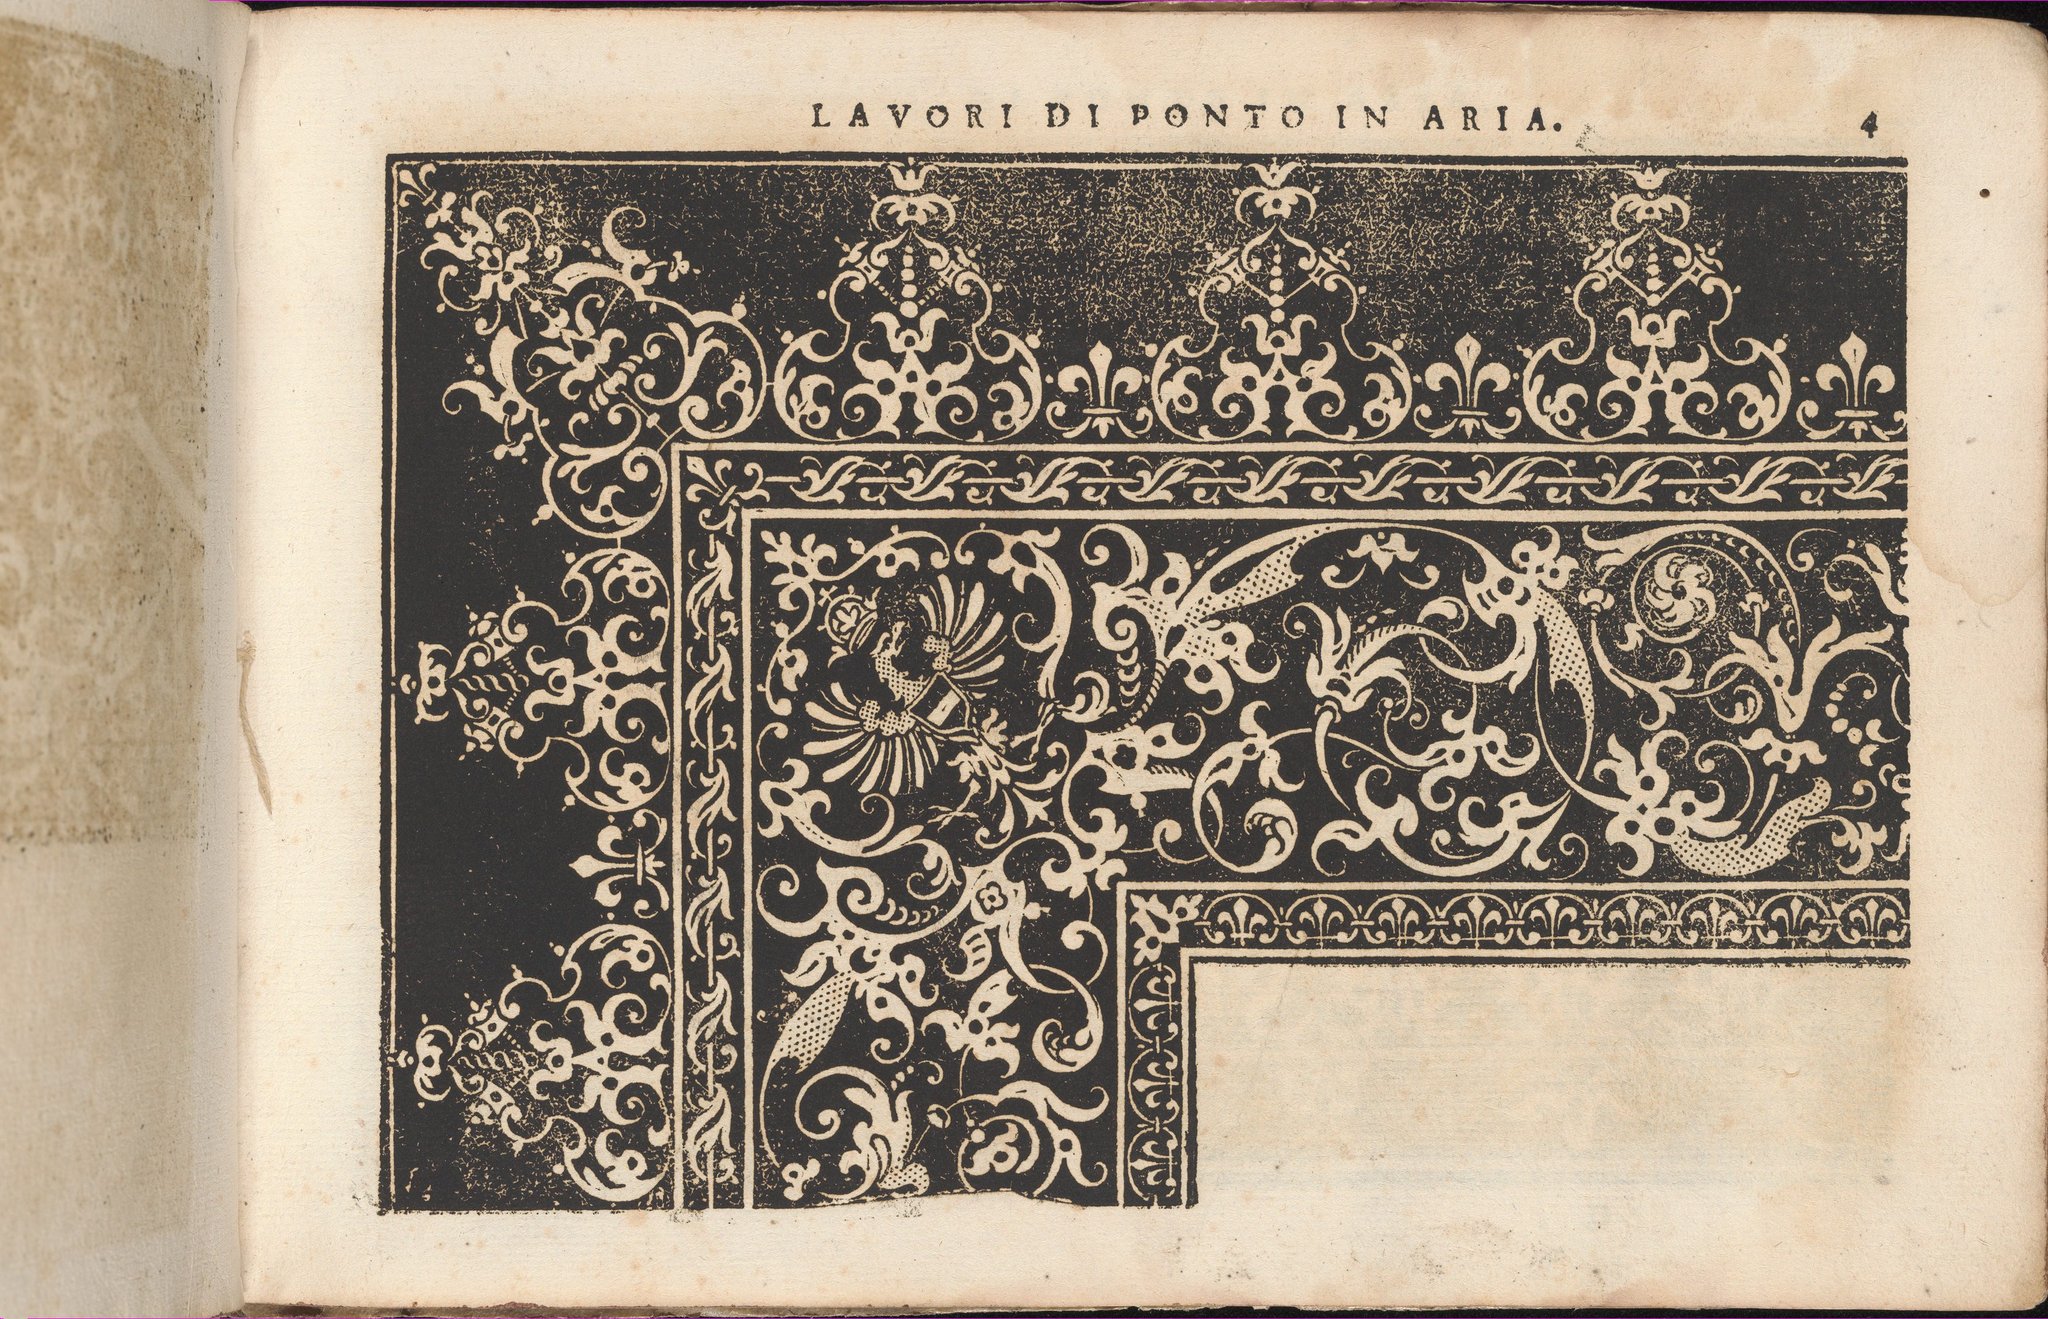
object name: book print ornament architecture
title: Teatro delle Nobili et Virtuose Donne..., page 12 (recto)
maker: isabella catanea parasole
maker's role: author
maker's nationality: italian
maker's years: 1565-1625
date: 1616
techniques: engraving, woodcut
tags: birds